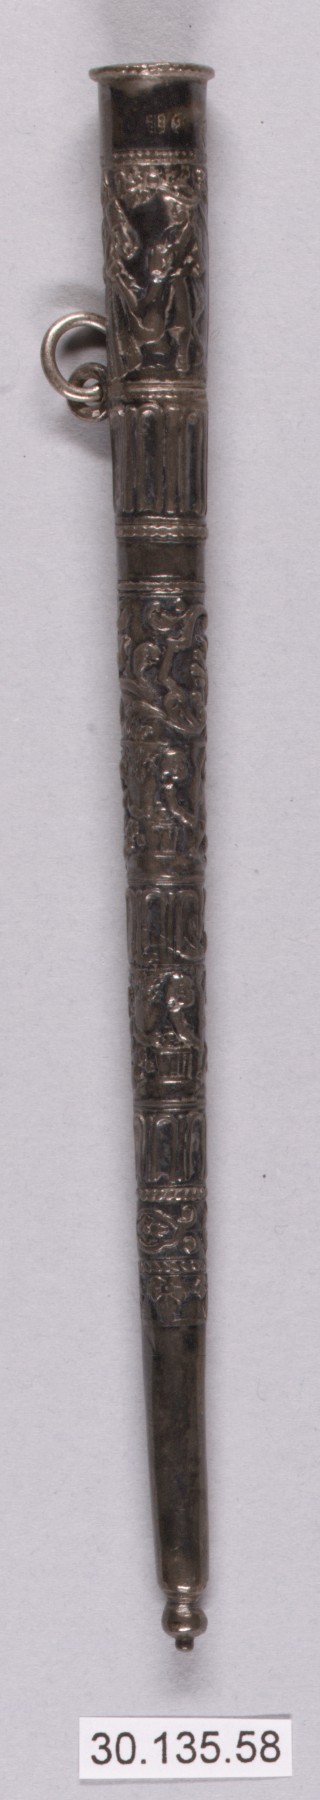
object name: needle sheath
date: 1667-1700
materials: silver